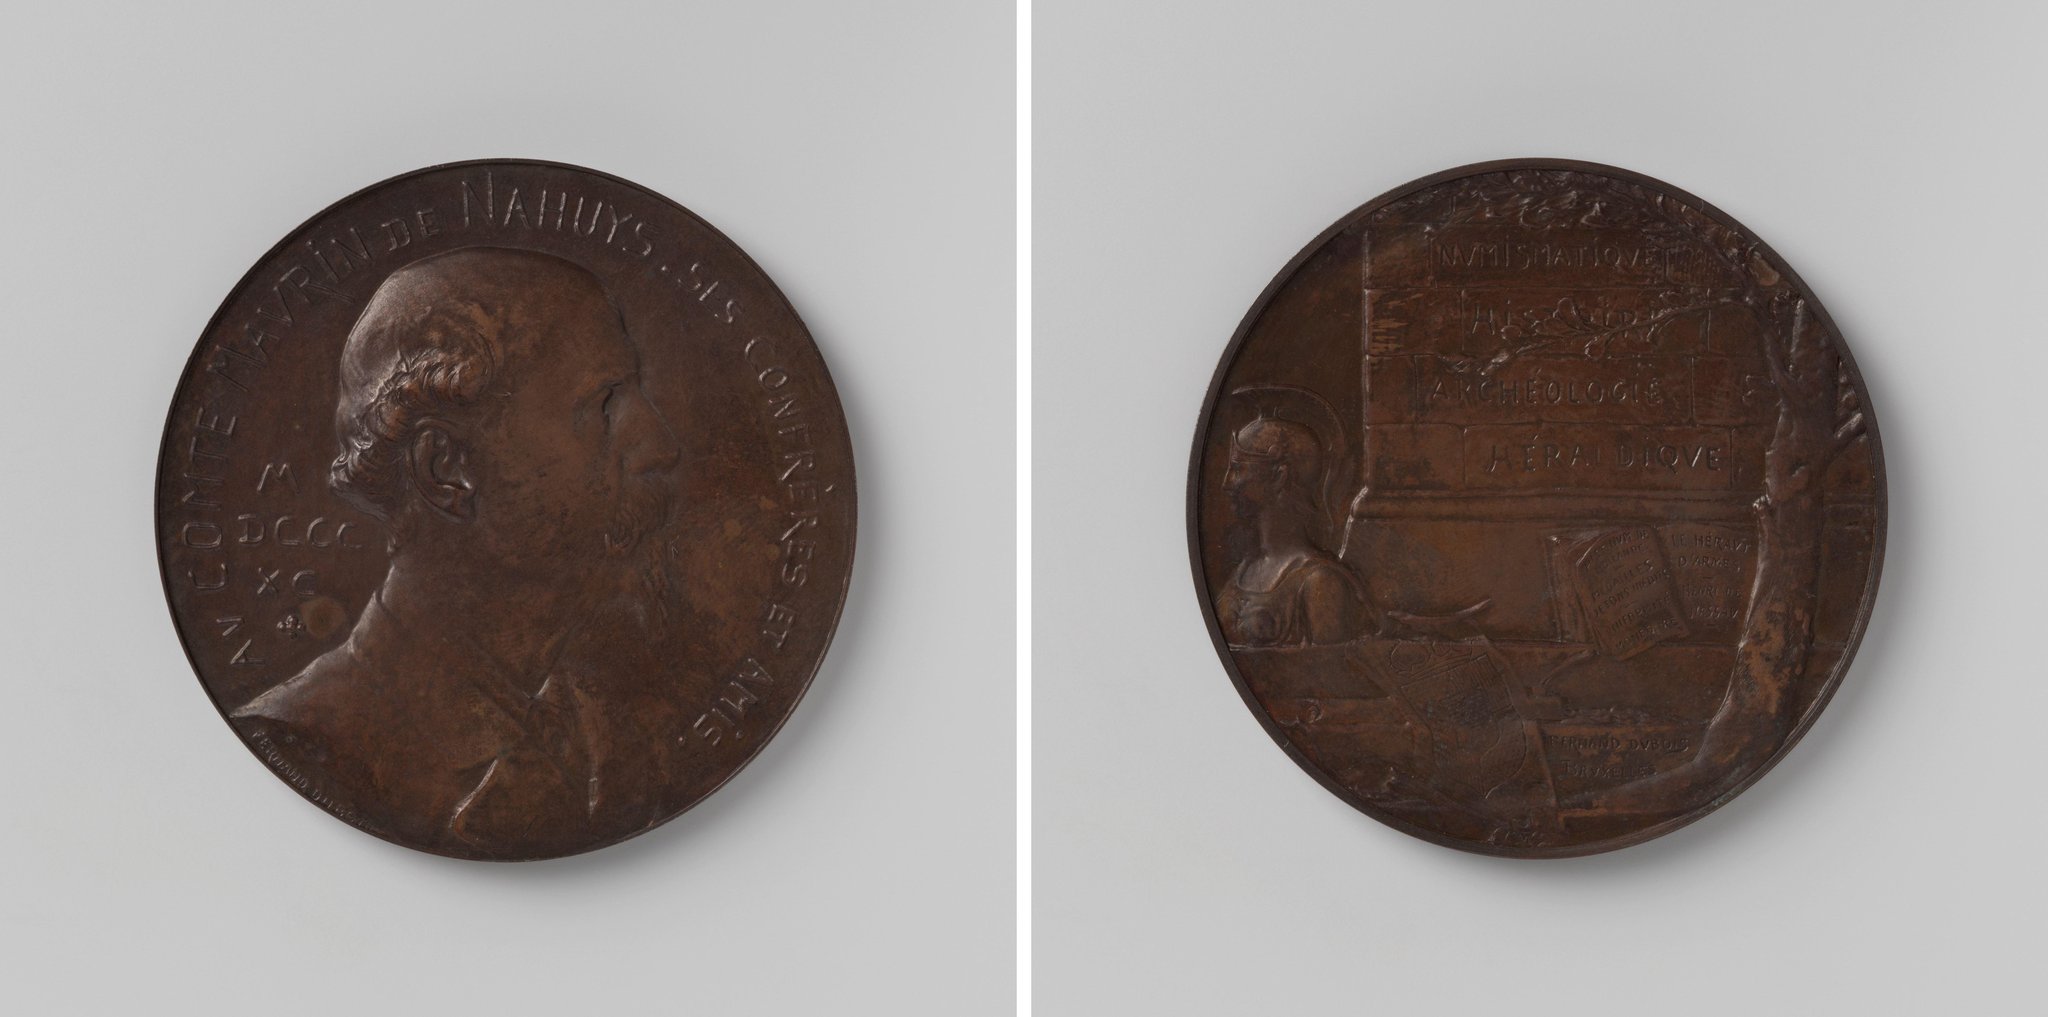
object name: medal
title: M.T.C.F.N. graaf Nahuys, numismaat en historicus, penning aangeboden door vrienden en collega's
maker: fernand dubois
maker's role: medailleur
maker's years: 1861-1911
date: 1890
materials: bronze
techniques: striking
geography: brussels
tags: belgium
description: Bronzen penning. Voorzijde: borststuk man in profiel naar rechts in randschrift. Keerzijde: monument waarop opschrift, naast boom. Aan de voet van het monument opengeslagen boek met tekst, olielampje, blad papier met wapen en gehelmd Grieks borstbeeld. Randschrift; Bronzen penning. Voorzijde: AV COMTE MAVRIN DE NAHUYS. SES CONFRERES ET AMIS. Keerzijde: NVMISMATIQVE / HISTOIRE / ARCHEOLOGIE / HERALDIQVE (+ in het boek:) HIST. NVM. DE / HOLLANDE / MEDAILLES / JETONS INEDITS. / VNIFORMATIE / MONETAIRE / LE HERAVT / D'ARMES / HENRI DE / NASSAV.